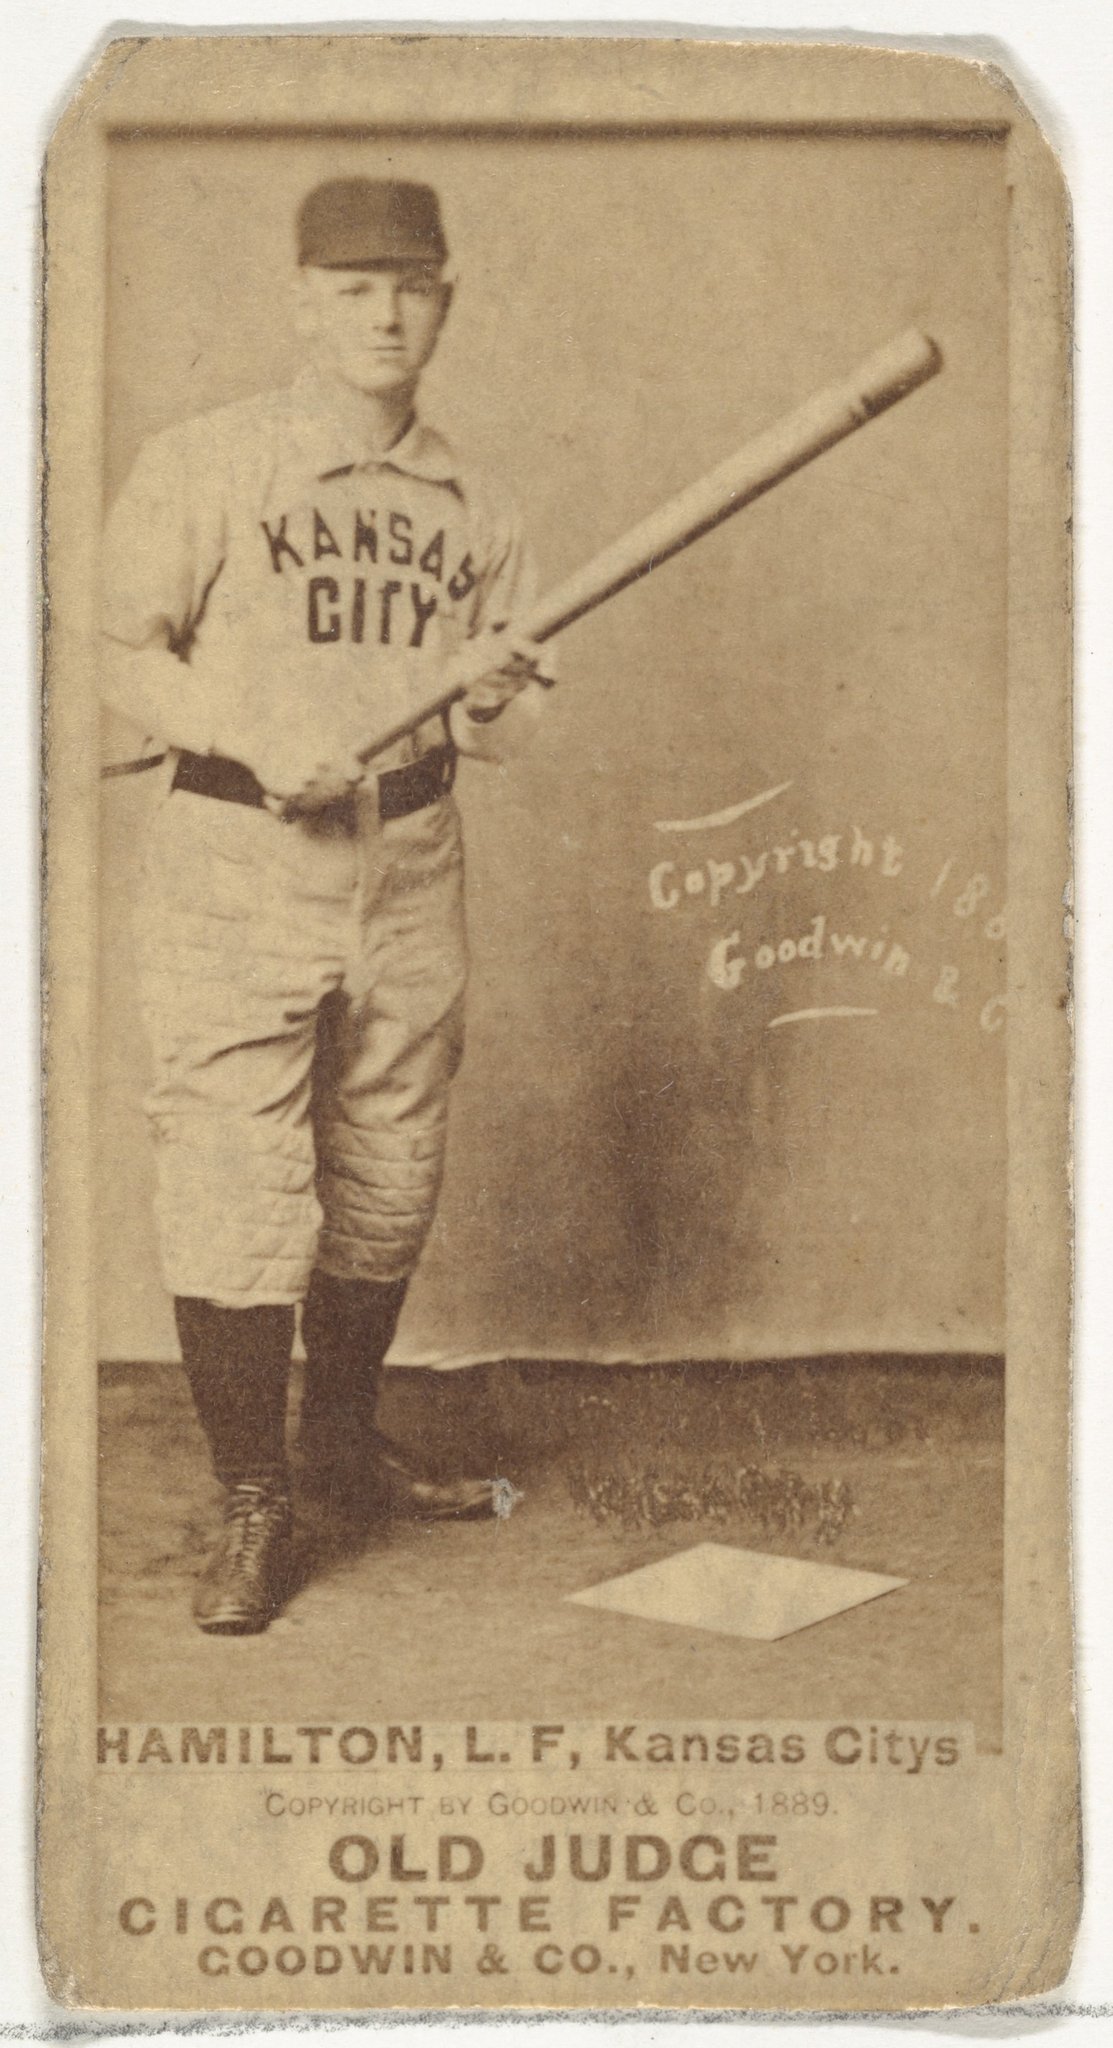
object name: baseball card, photograph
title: William Robert "Sliding Billy" Hamilton, Left Field, Kansas City Cowboys, from the Old Judge series (N172) for Old Judge Cigarettes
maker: goodwin & company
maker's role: publisher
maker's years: 1850-1950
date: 1889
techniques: albumen silver print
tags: men,portraits,baseball,athletes